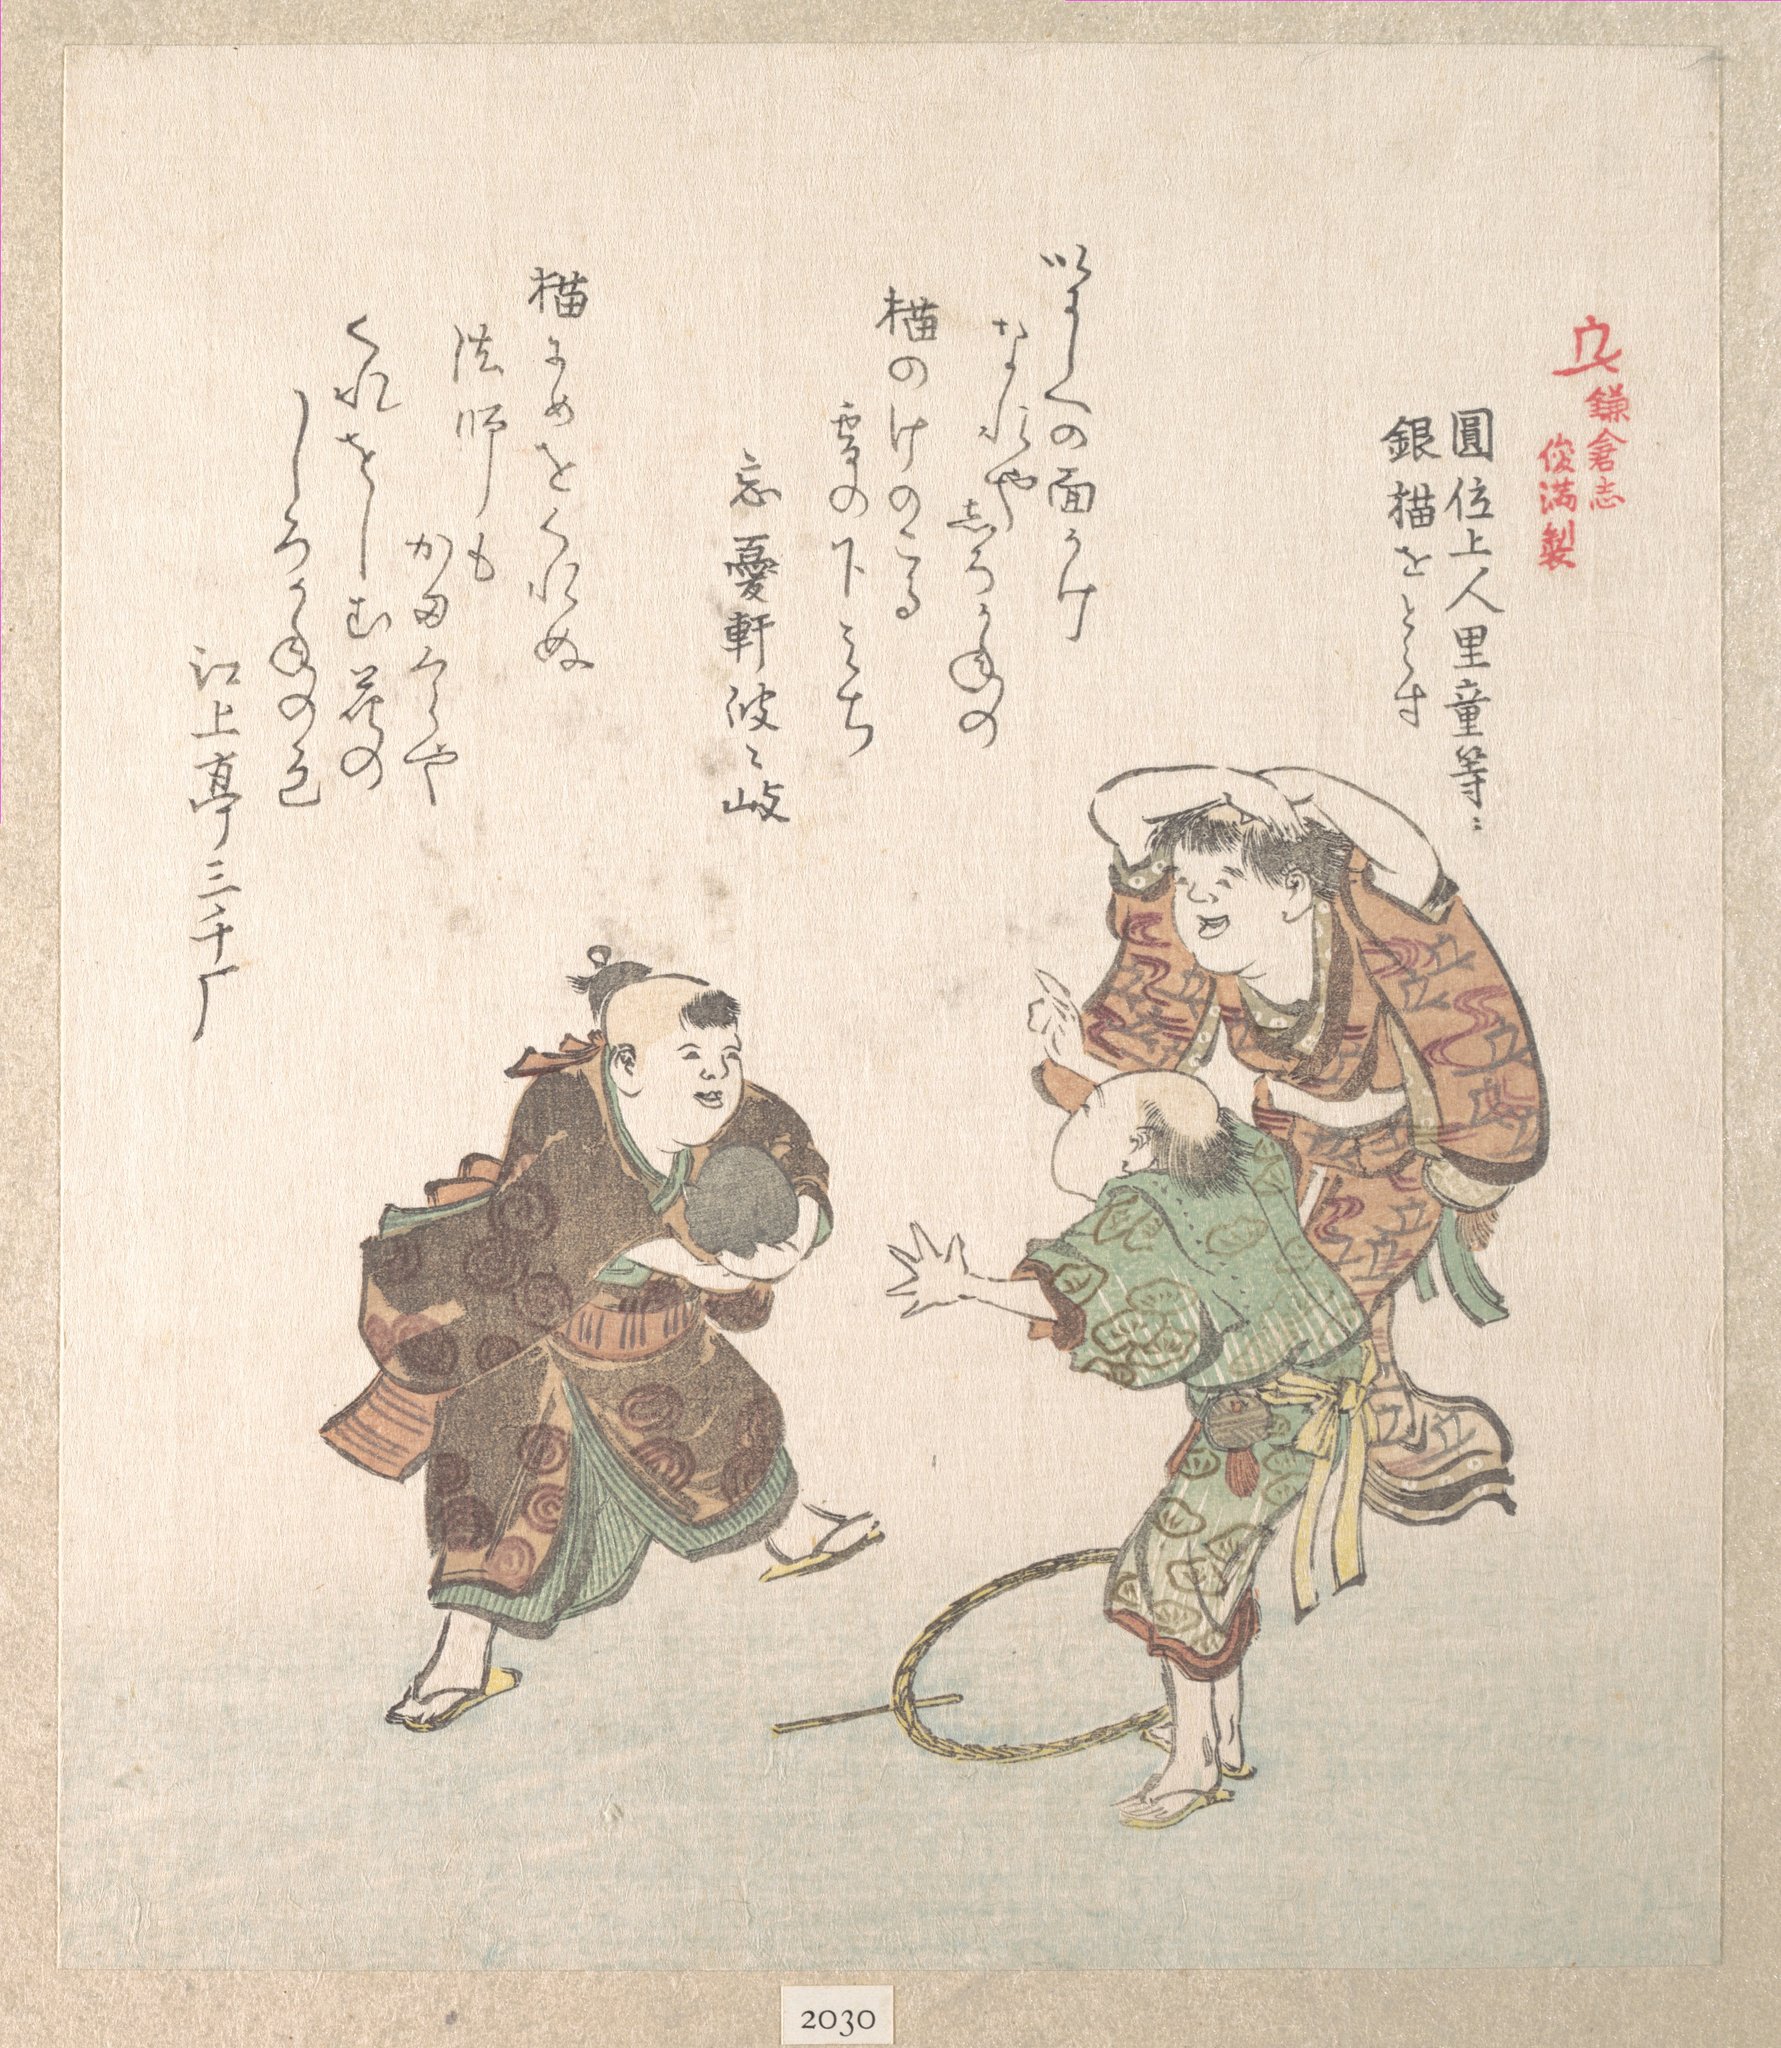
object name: print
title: History of Kamakura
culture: japanese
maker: kubo shunman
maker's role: artist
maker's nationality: japanese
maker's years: 1757-1820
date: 1801-1900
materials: ink, paper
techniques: surimono, woodblock print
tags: boys